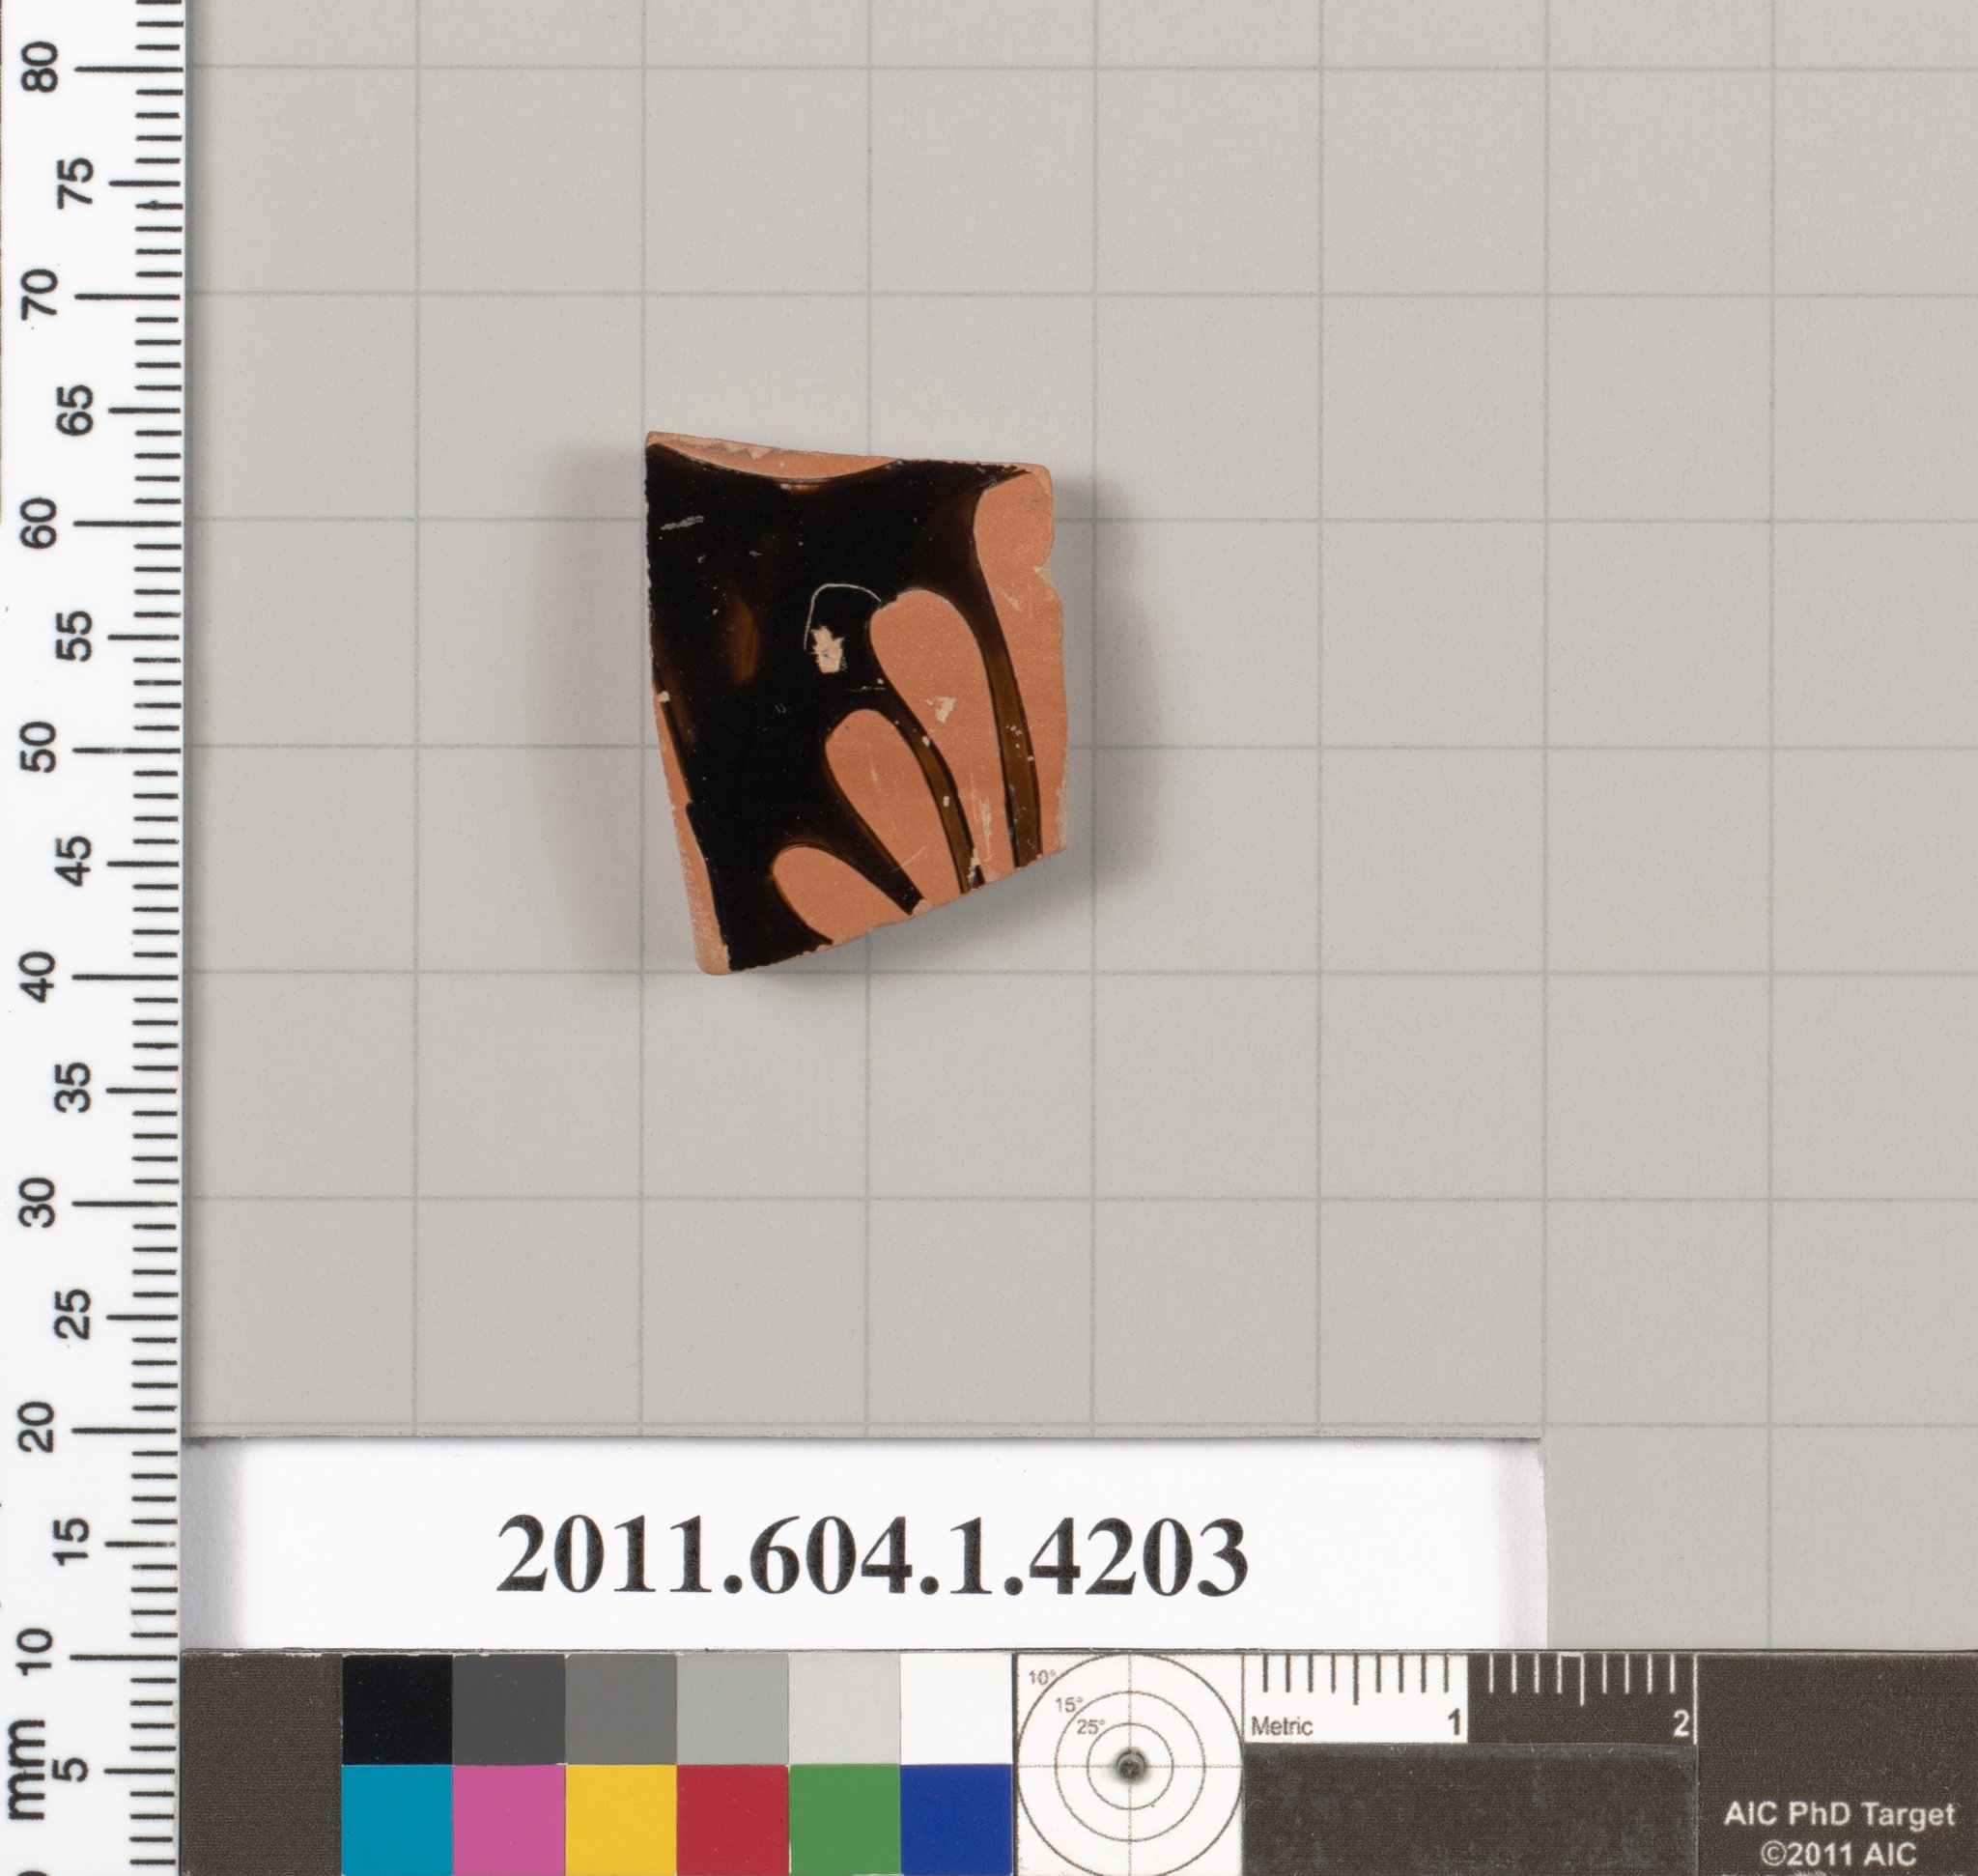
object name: kylix fragment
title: Terracotta fragment of a kylix (drinking cup)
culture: greek, attic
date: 500-476 BCE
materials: terracotta